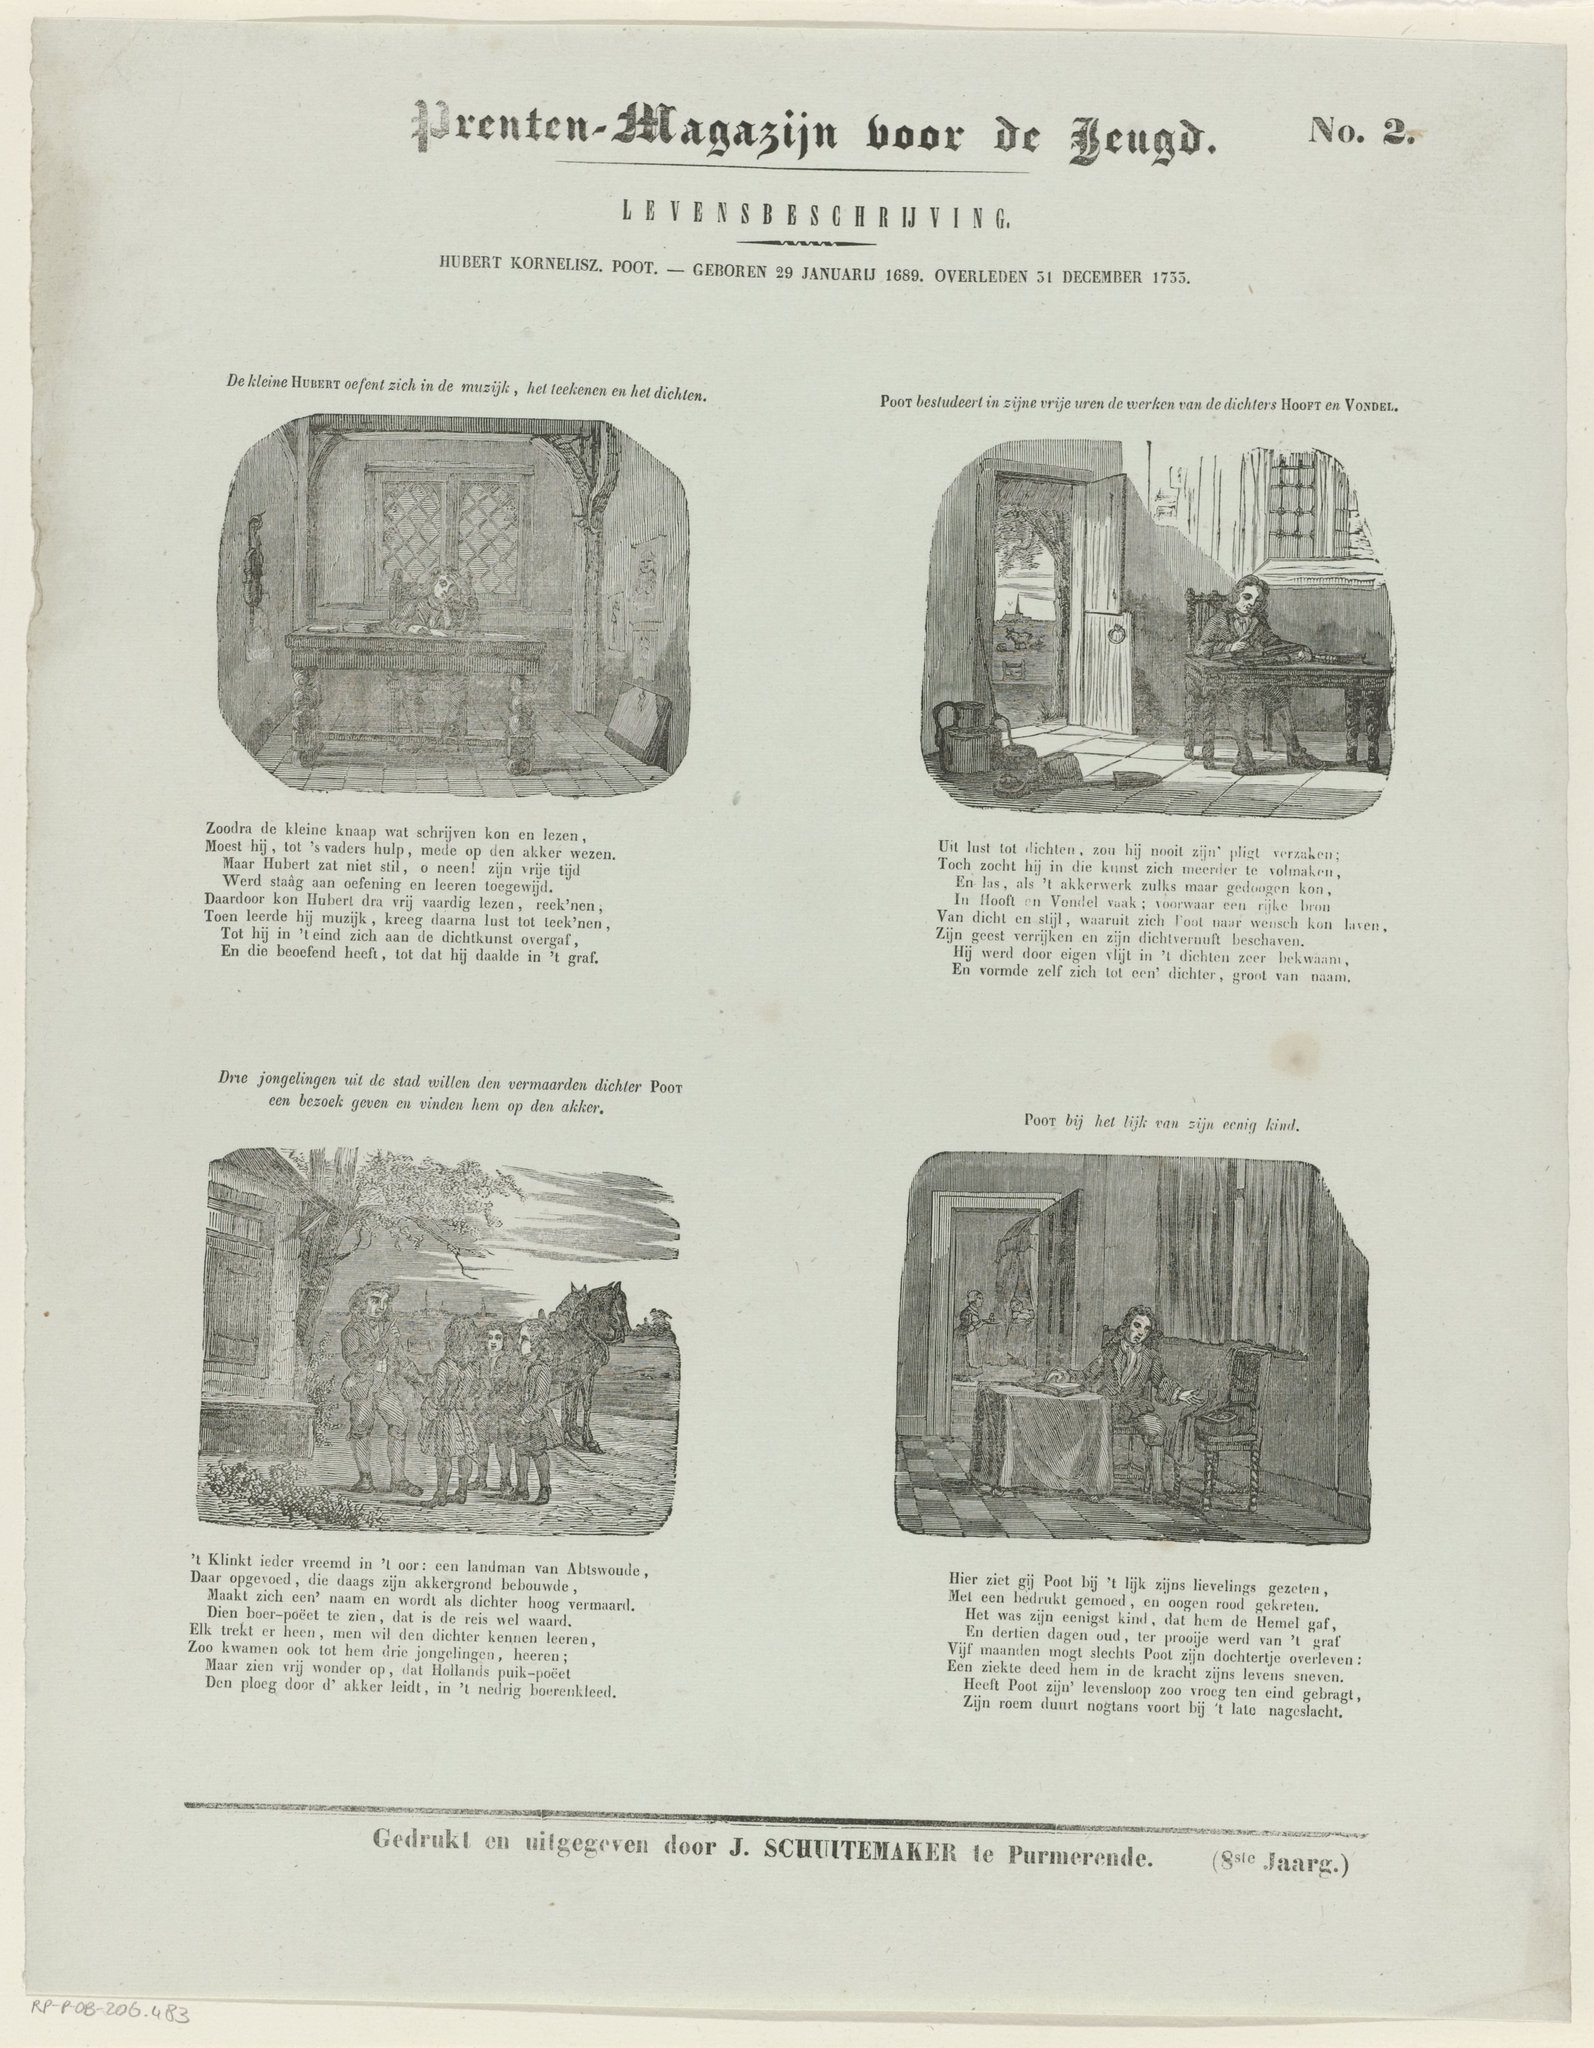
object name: print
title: Hubert Cornelisz. Poot. - geboren 29 Januarij 1689. Overleden 31 December 1733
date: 1849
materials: paper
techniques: letterpress printing, engraving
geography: netherlands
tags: delft, hubert kornelisz. poot, historical persons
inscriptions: collector's mark: Lugt 2760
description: Blad met 4 voorstellingen uit het leven van Hubert Kornelisz. Poot. Boven elke voorstelling een titel en onder elke voorstelling een achtregelig vers. Genummerd rechtsboven: No. 2.